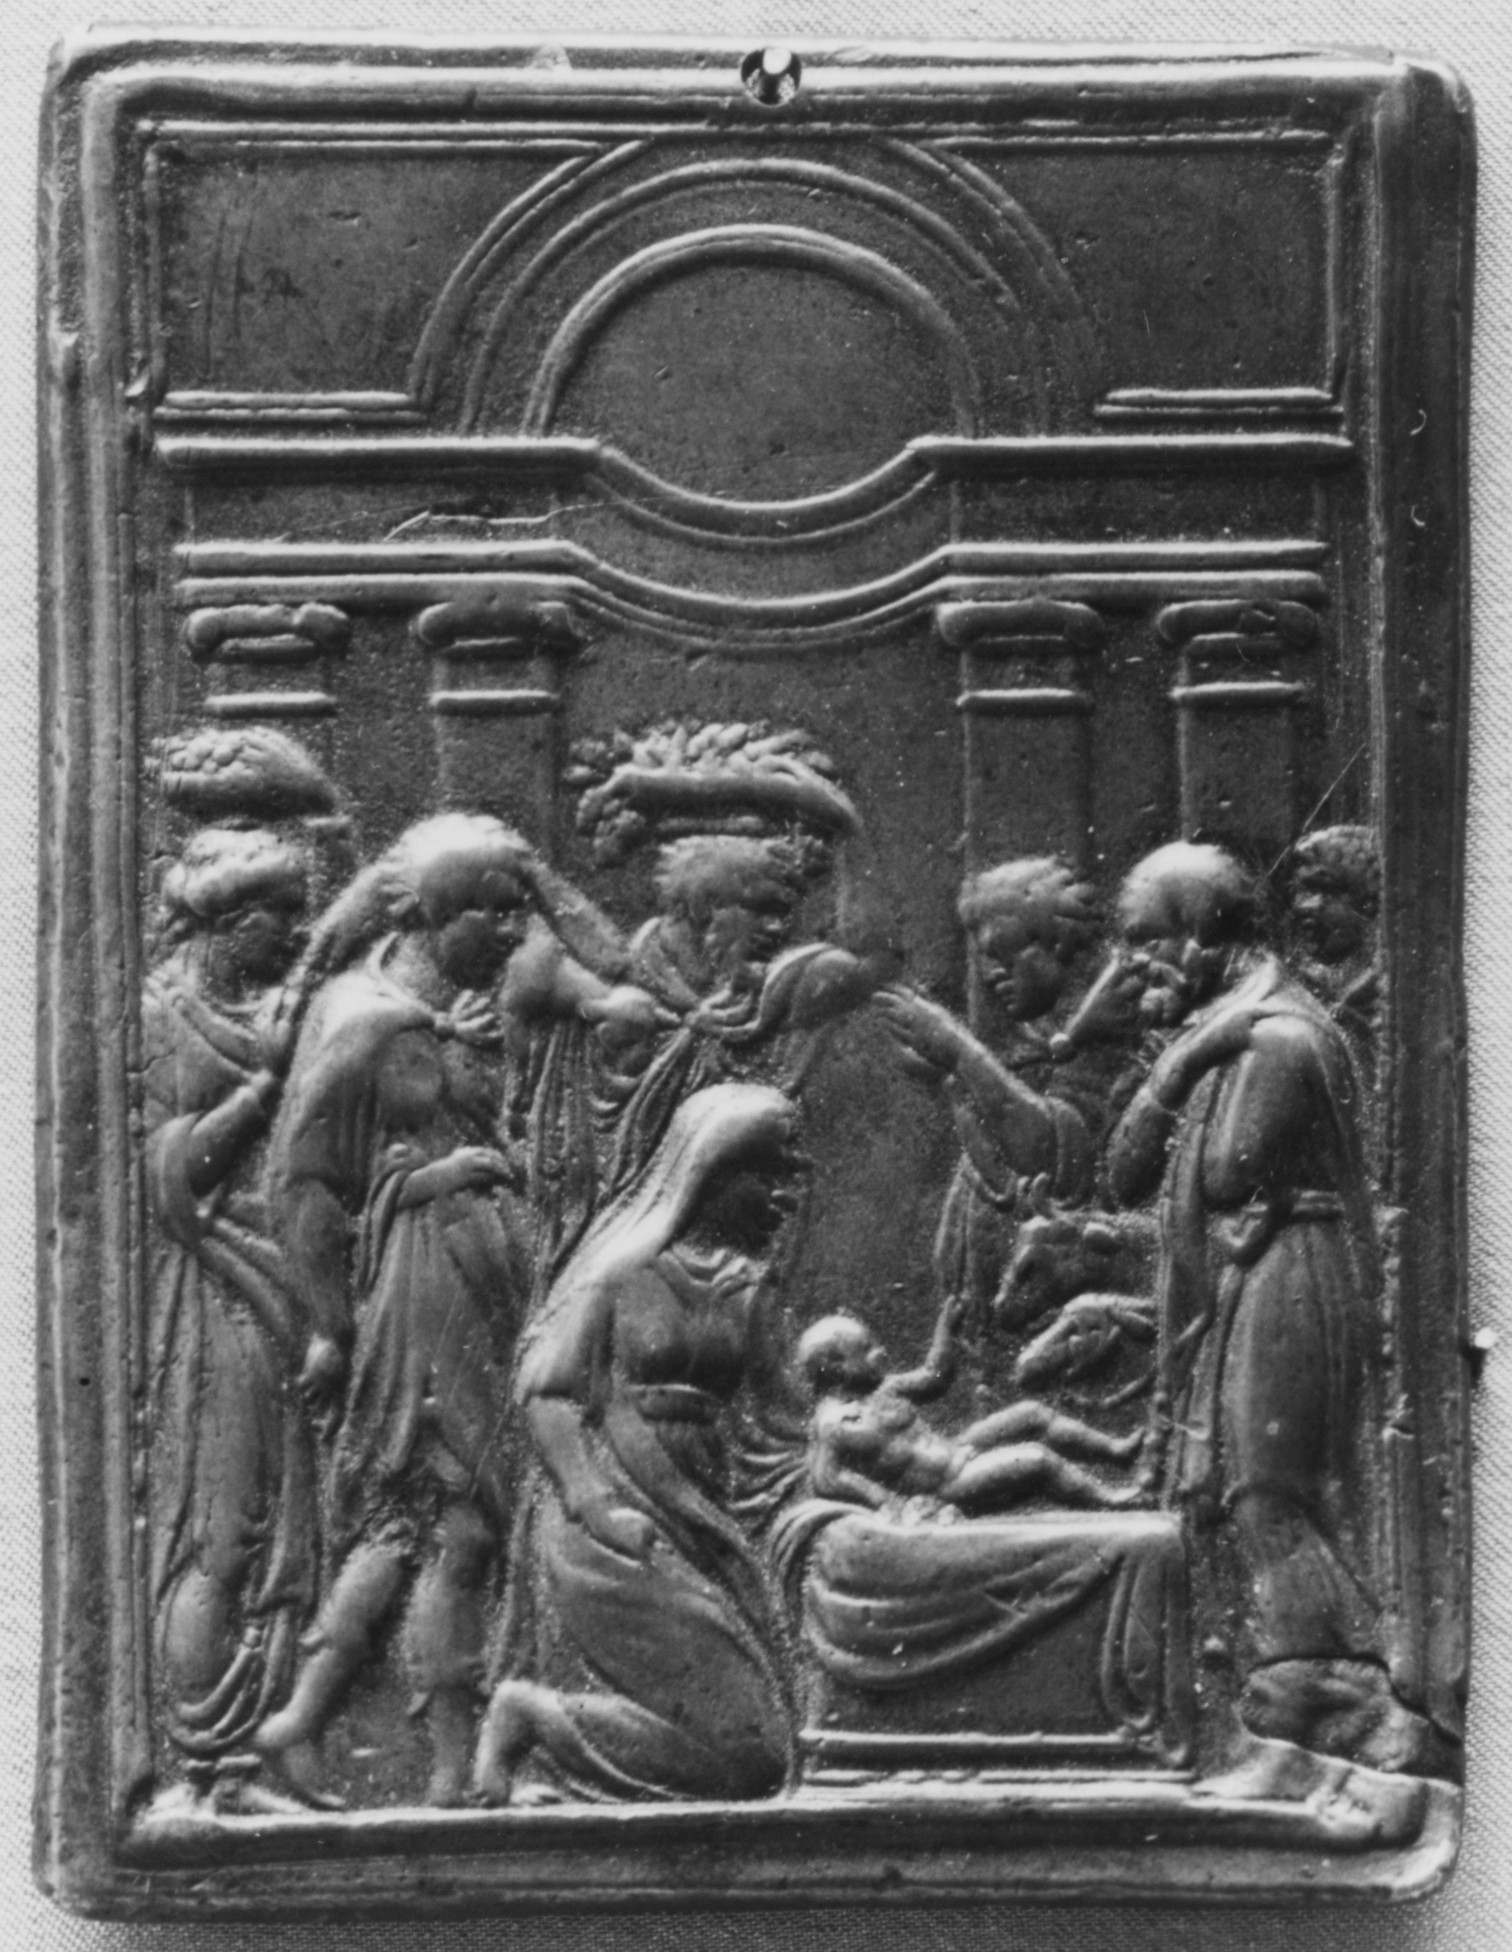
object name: plaquette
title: Adoration of the Shepherds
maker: valerio belli (il vicentino)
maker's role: artist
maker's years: 1468-1546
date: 1501-1600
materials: bronze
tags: men,women,jesus,adoration of the shepherds